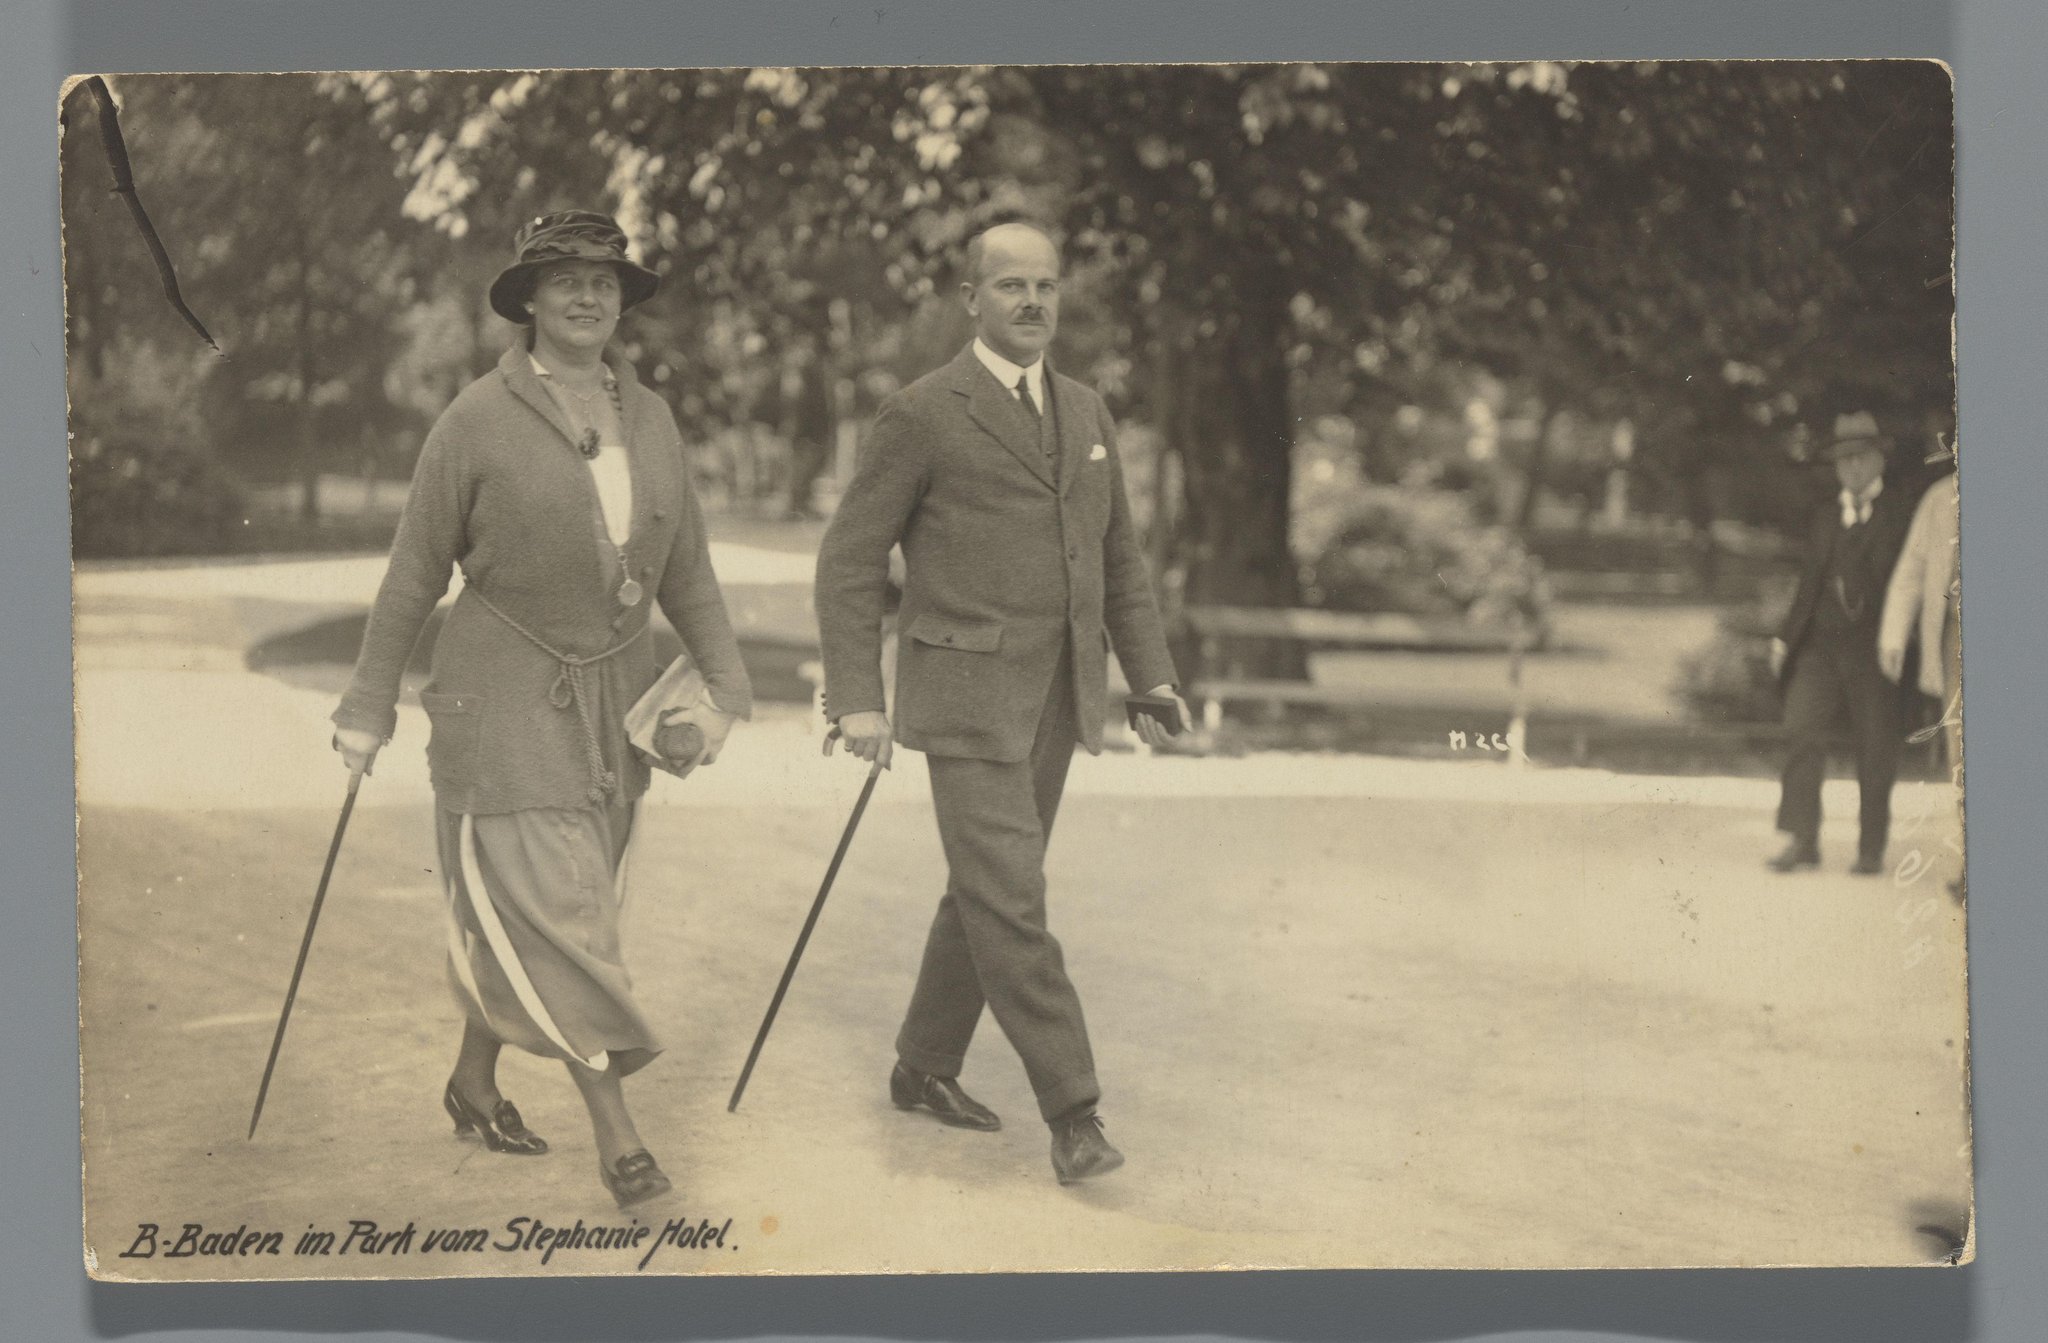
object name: photograph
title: Line van den Berg en Hendrik Herman van den Berg wandelend in een park te Baden-Baden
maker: Anonymous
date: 1921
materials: photographic support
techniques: photography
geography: baden-baden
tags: batavia, amsterdam, hendrik herman van den berg, the hague, caroline louise van den berg-van den berg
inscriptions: inscription, inscription: ‘B-Baden im Park vom Stephanie Hotel’, stamp, seal